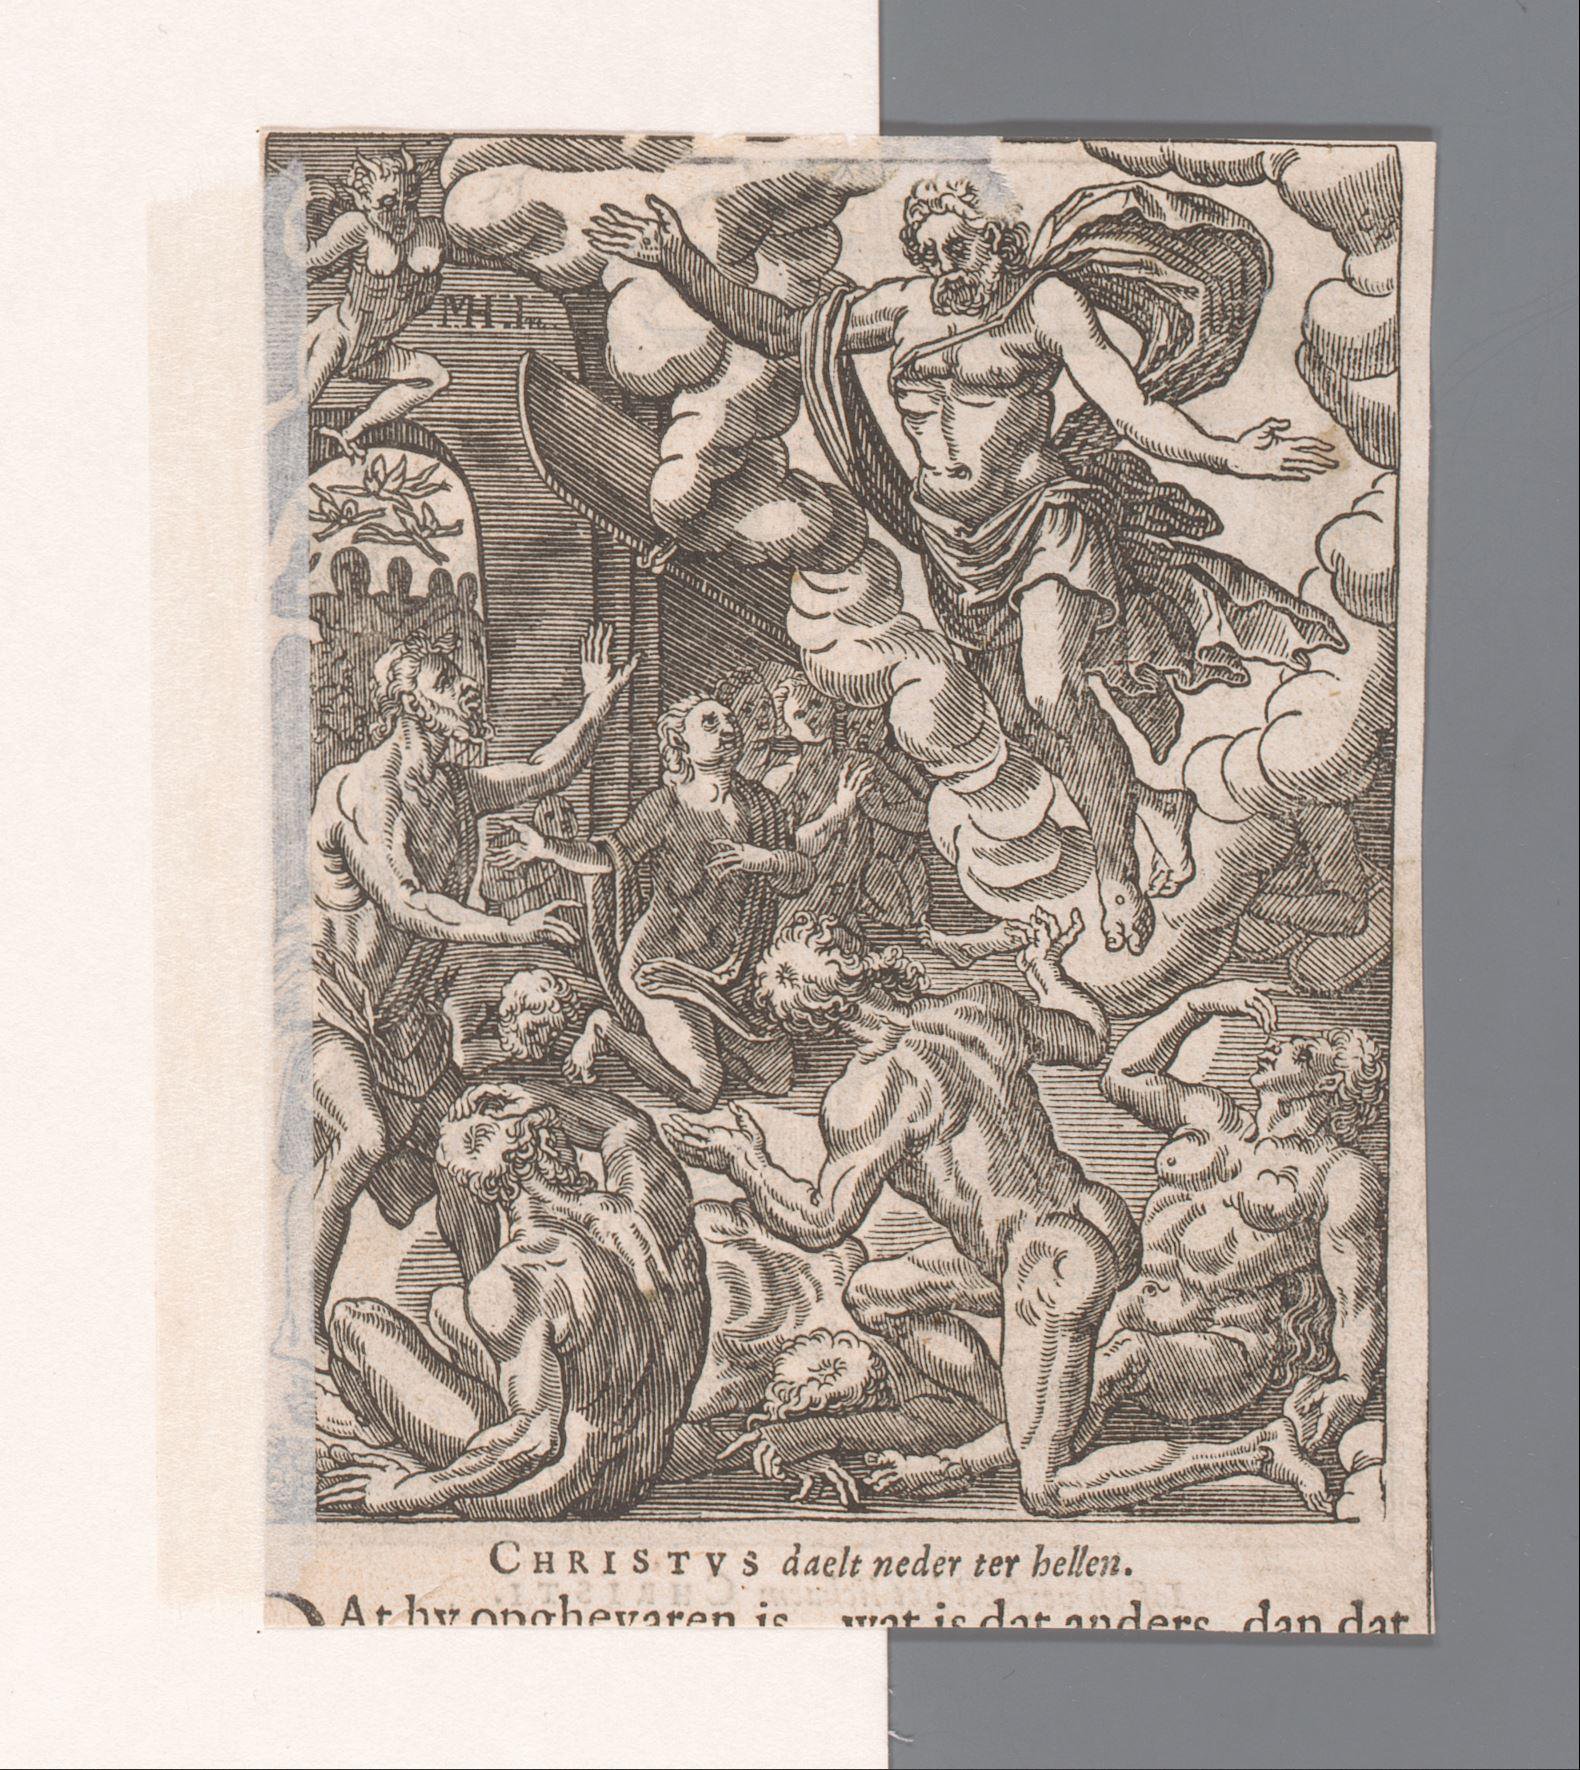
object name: book illustration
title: Christus daelt neder ter hellen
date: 1648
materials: paper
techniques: letterpress printing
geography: amsterdam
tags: christ enters hell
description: Prent uit: 't Schat der Zielen, dat is, het geheele leven ons Heeren Iesu Christi naer de vyer Evangelisten (...) in zeven stucken verdeelt. Amsterdam: Pieter Jacobsz. Paets, 1648. Deze prent komt uit het vijfde deel of hoofdstuk van 't Schat der zielen: Passie ons Heeren Iesu Christi, naer de beschrijvinghe van de vier evangelisten. Binnen het vijfde deel hoort deze prent bij de beschrijving van de passie door Lucas.